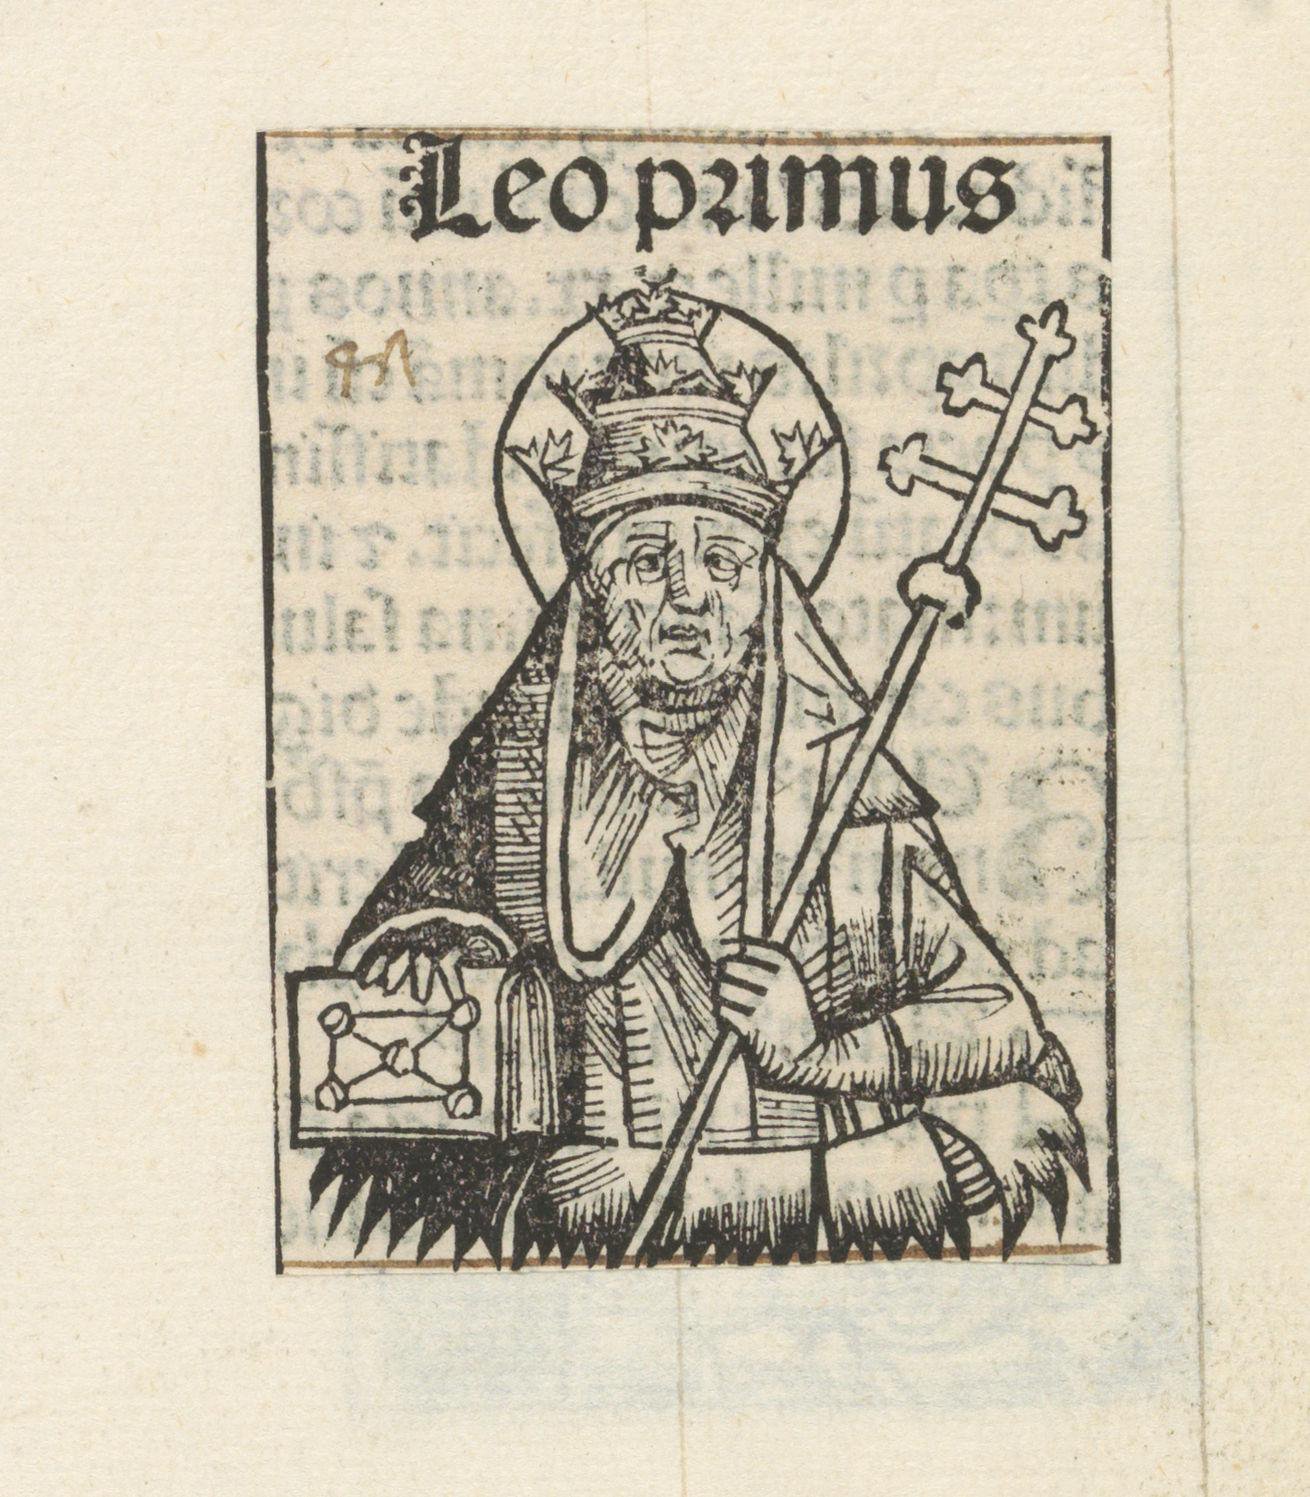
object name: album leaf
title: Leo primus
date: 1493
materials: paper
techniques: letterpress printing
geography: nuremberg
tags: rome, pope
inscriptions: inscription: ‘47’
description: Een bloemkelk met een paus. Hij draagt een tiara en heeft een bijbel en een staf met een dubbel kruis in zijn handen. De nimbus om het hoofd van de paus vertelt dat de man heilig is verklaard. De voorstelling is onderdeel van de opeenvolging pausen in de Liber Chronicarum. De tekst identificeert de man als Leo I. De prent maakt deel uit van een album.